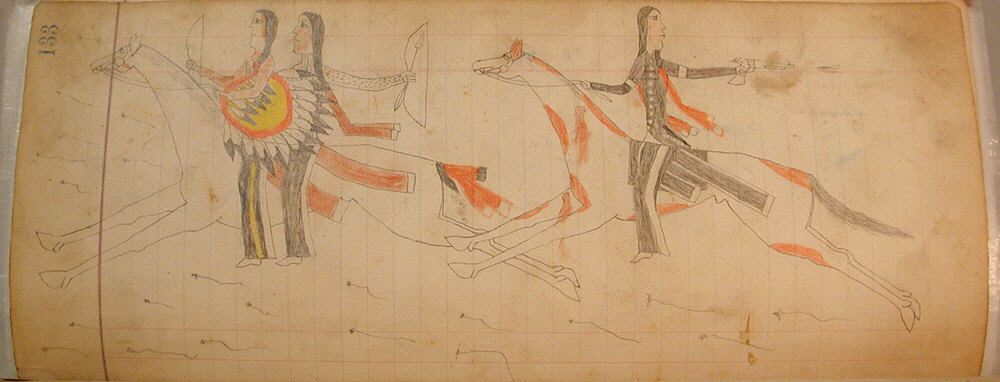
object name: drawing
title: Maffet Ledger: Drawing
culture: cheyenne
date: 1874-1881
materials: crayon, graphite, paper, watercolor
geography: united states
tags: weapons,men,horses